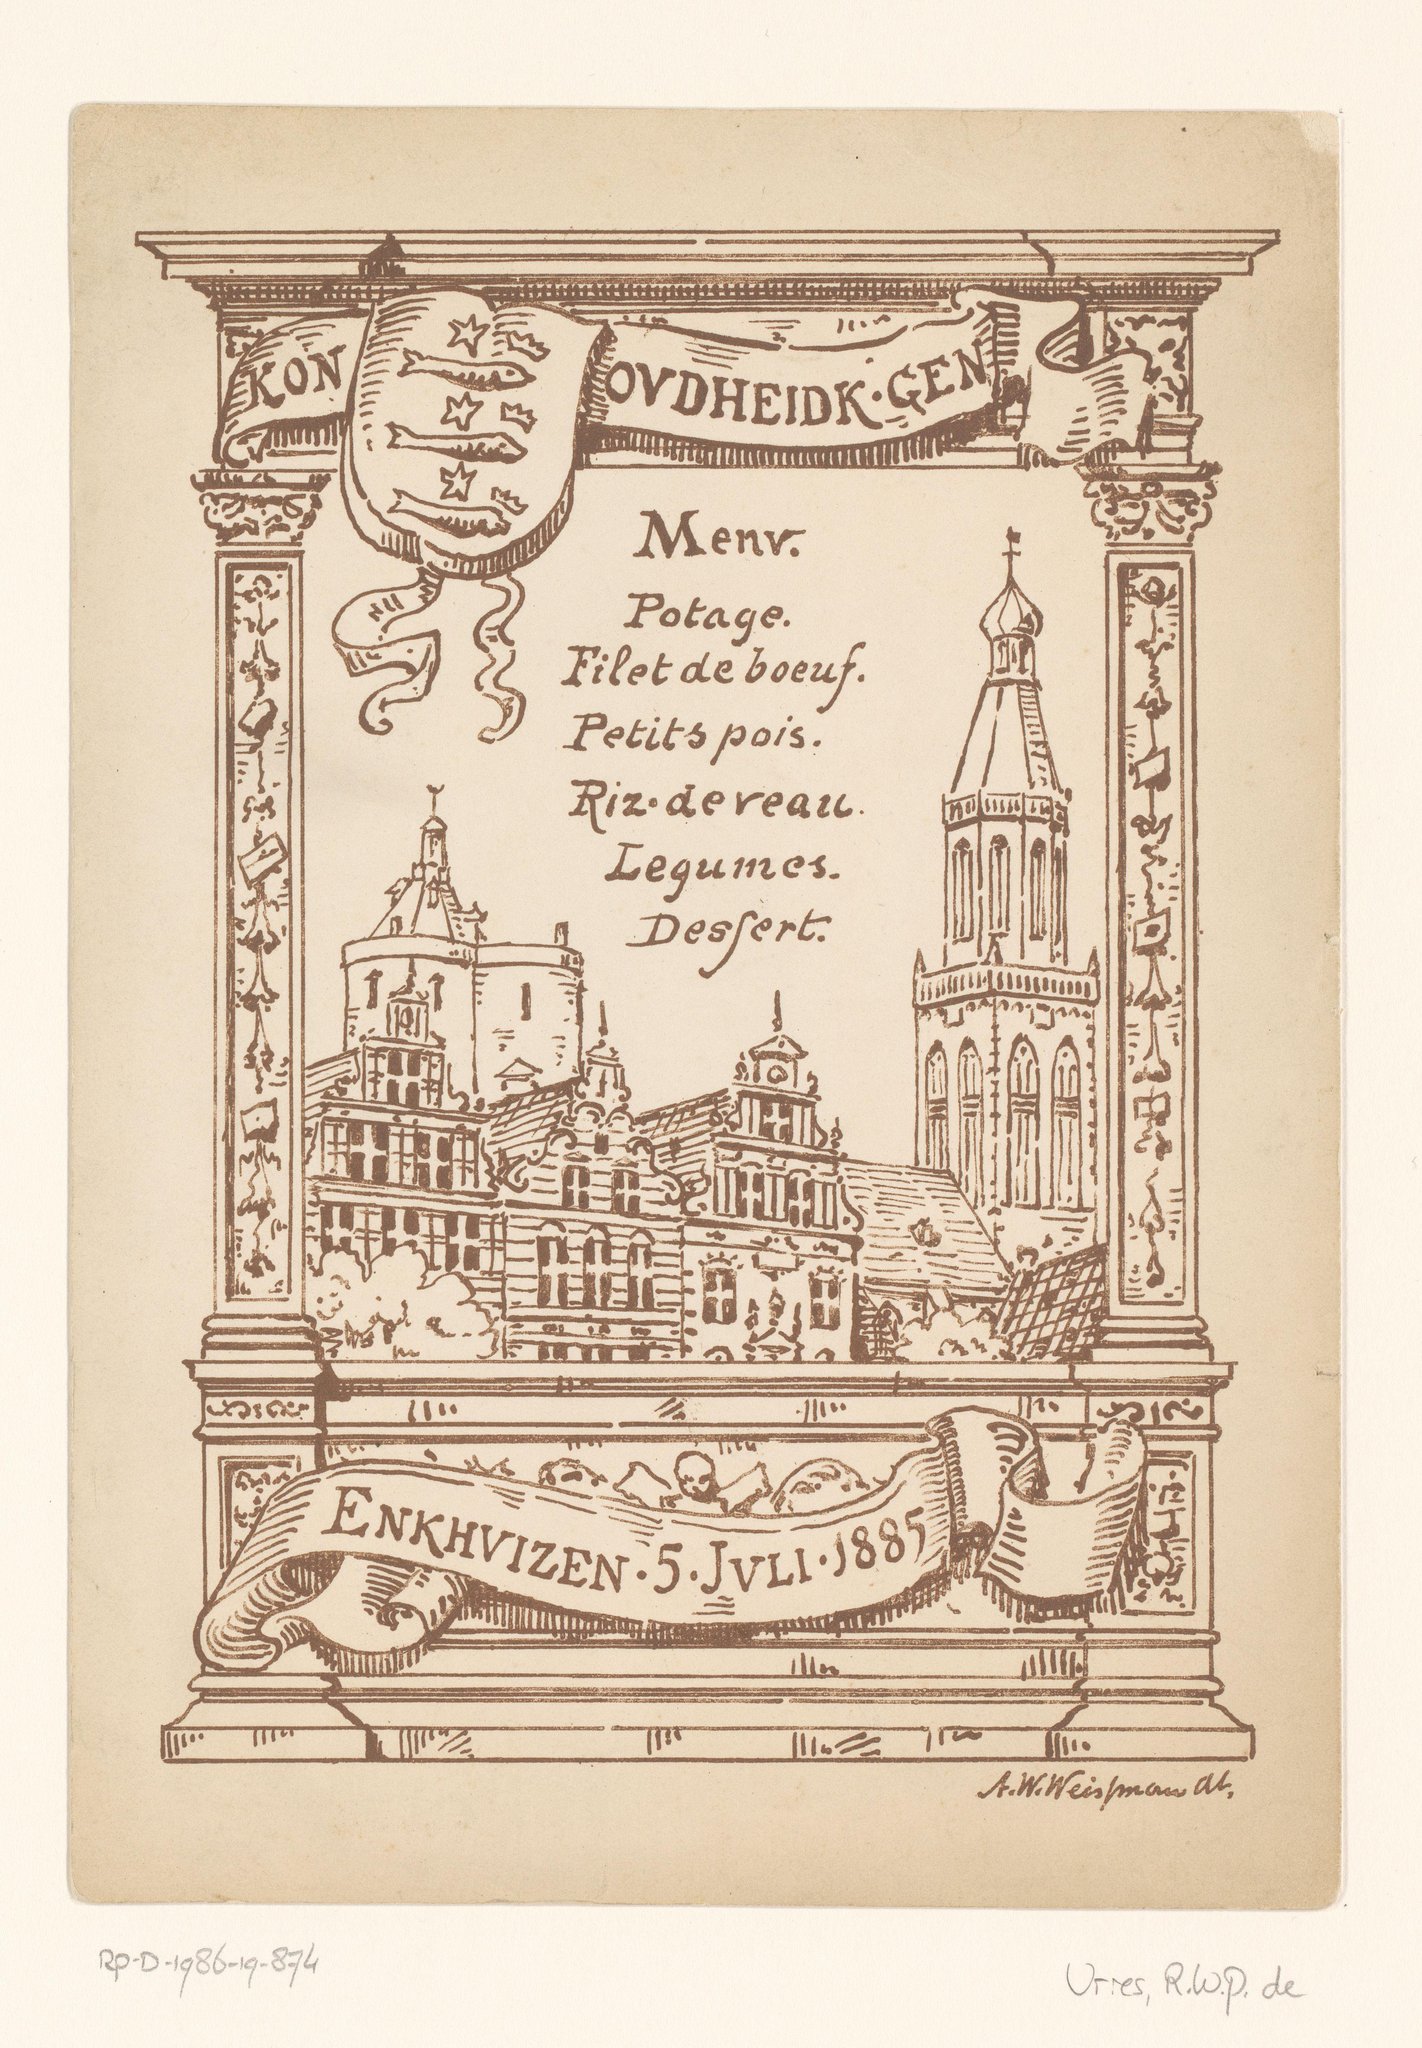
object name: print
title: Menukaart met gezicht op Enkhuizen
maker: adriaan willem weissman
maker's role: architect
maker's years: 1858-1923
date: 1885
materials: paper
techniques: lithograph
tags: coat of arms (as symbol of the state, etc.), city-view, and landscape with man-made constructions, enkhuizen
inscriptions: date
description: Gezicht op Enkhuizen in een architecturale omlijsting met rechts de torenspits van de Zuiderkerk en links de Drommedaris. Bovenaan het wapen van Enkhuizen en de menukaart bij een bijeenkomst van het Koninklijk Oudheidkundig Genootschap.